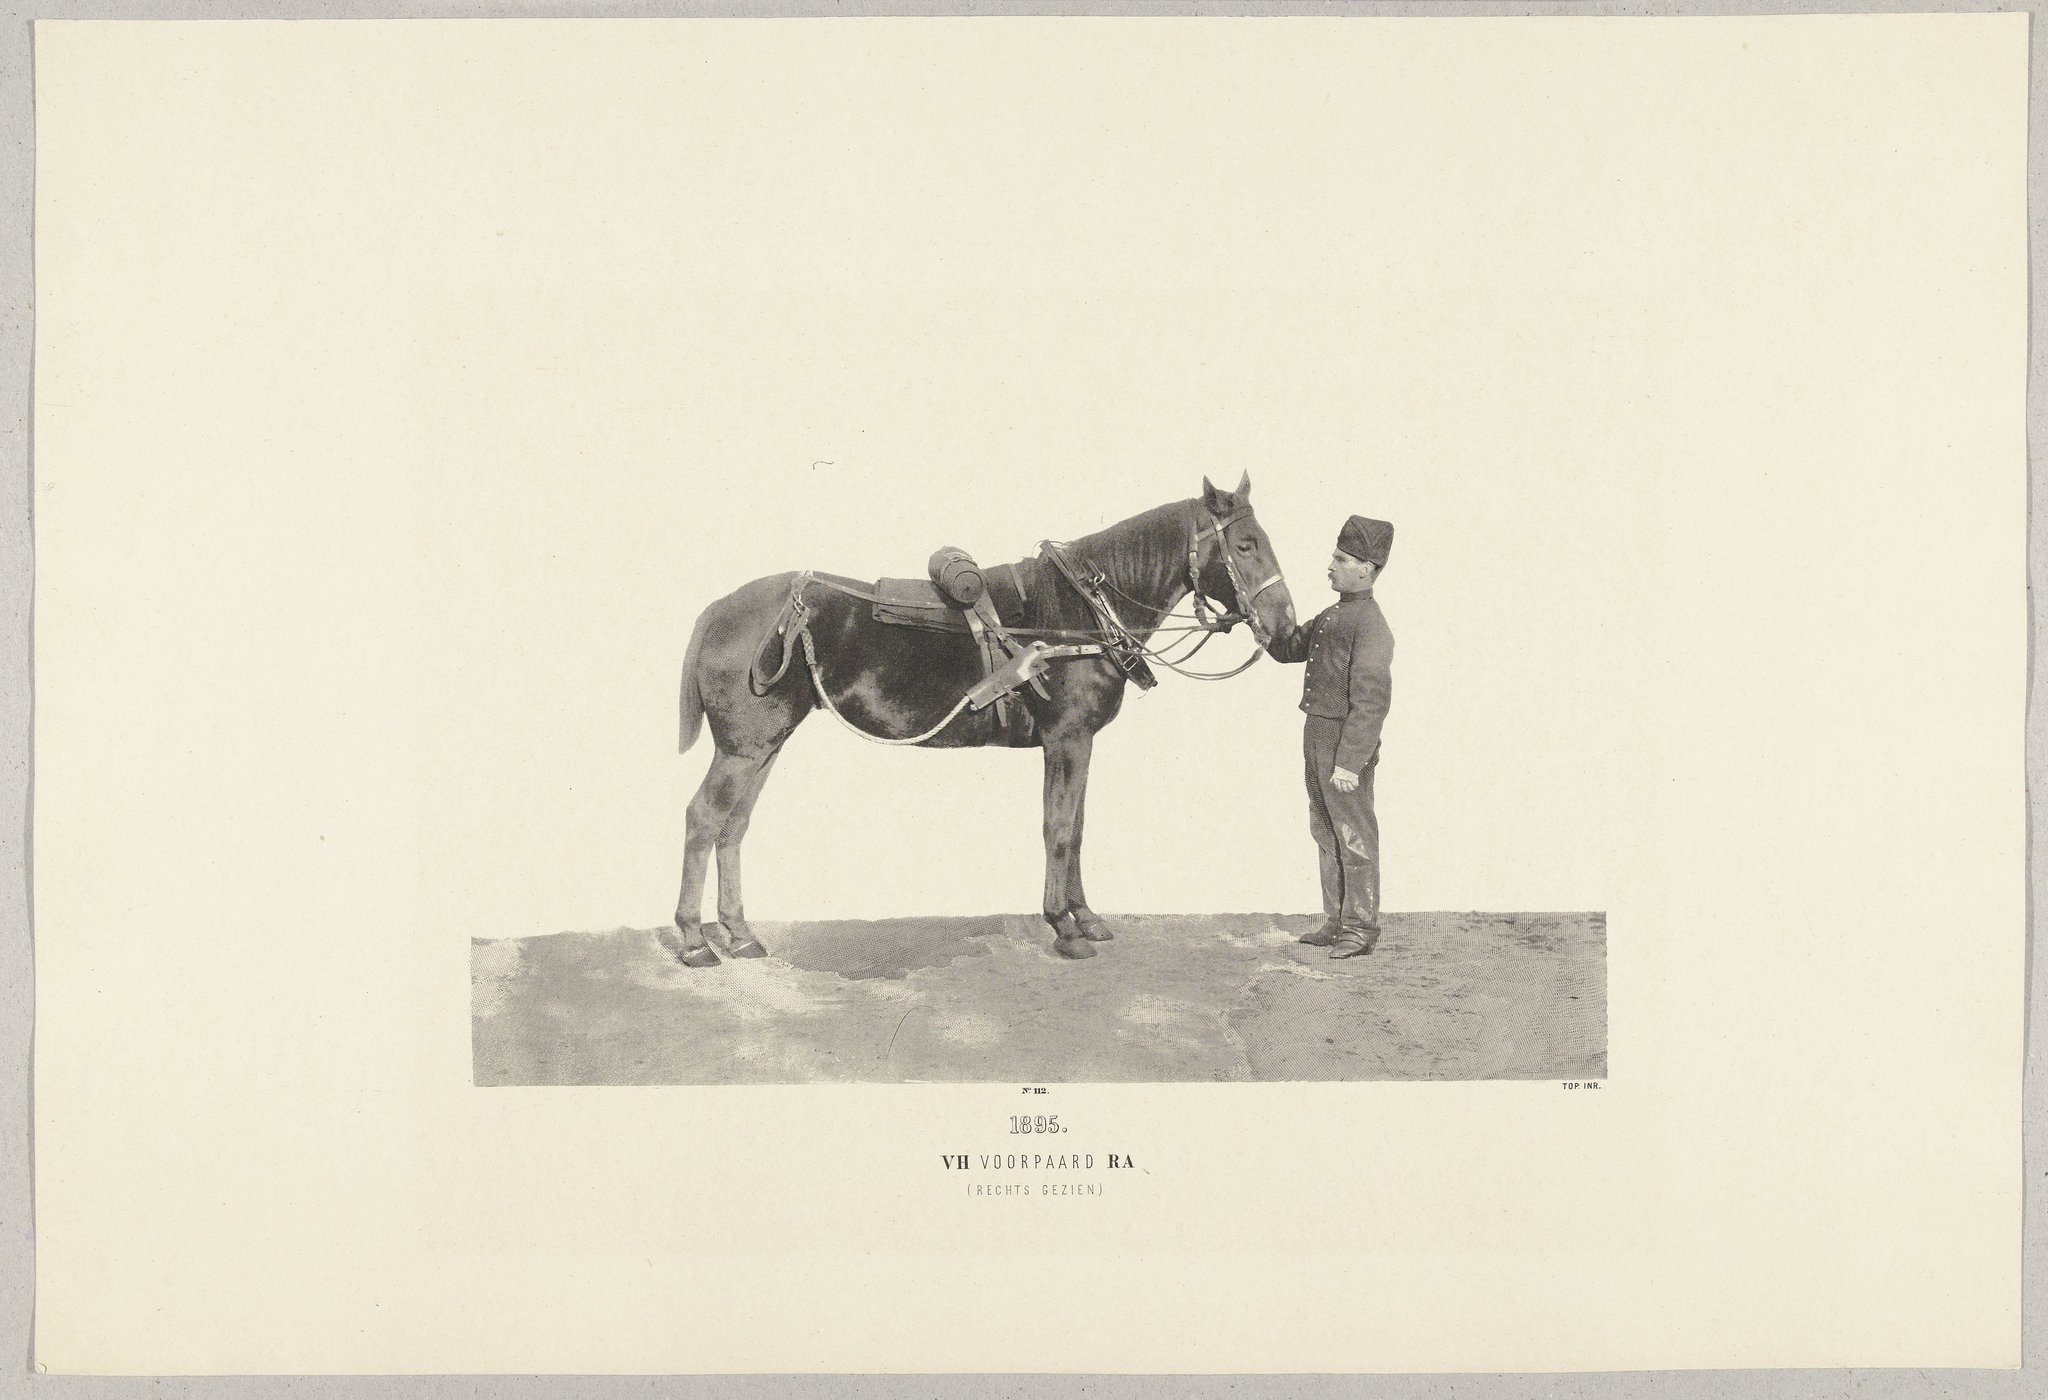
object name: photomechanical print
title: Opgezadeld legerpaard, en profil gezien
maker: Anonymous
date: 1895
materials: paper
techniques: photolithography, rotogravure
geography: netherlands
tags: saddling and bridling, horse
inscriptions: inscription: ‘No 112/ TOP.INR./ 1895./ BH VOORPAARD RA/ (RECHTS GEZIEN)’